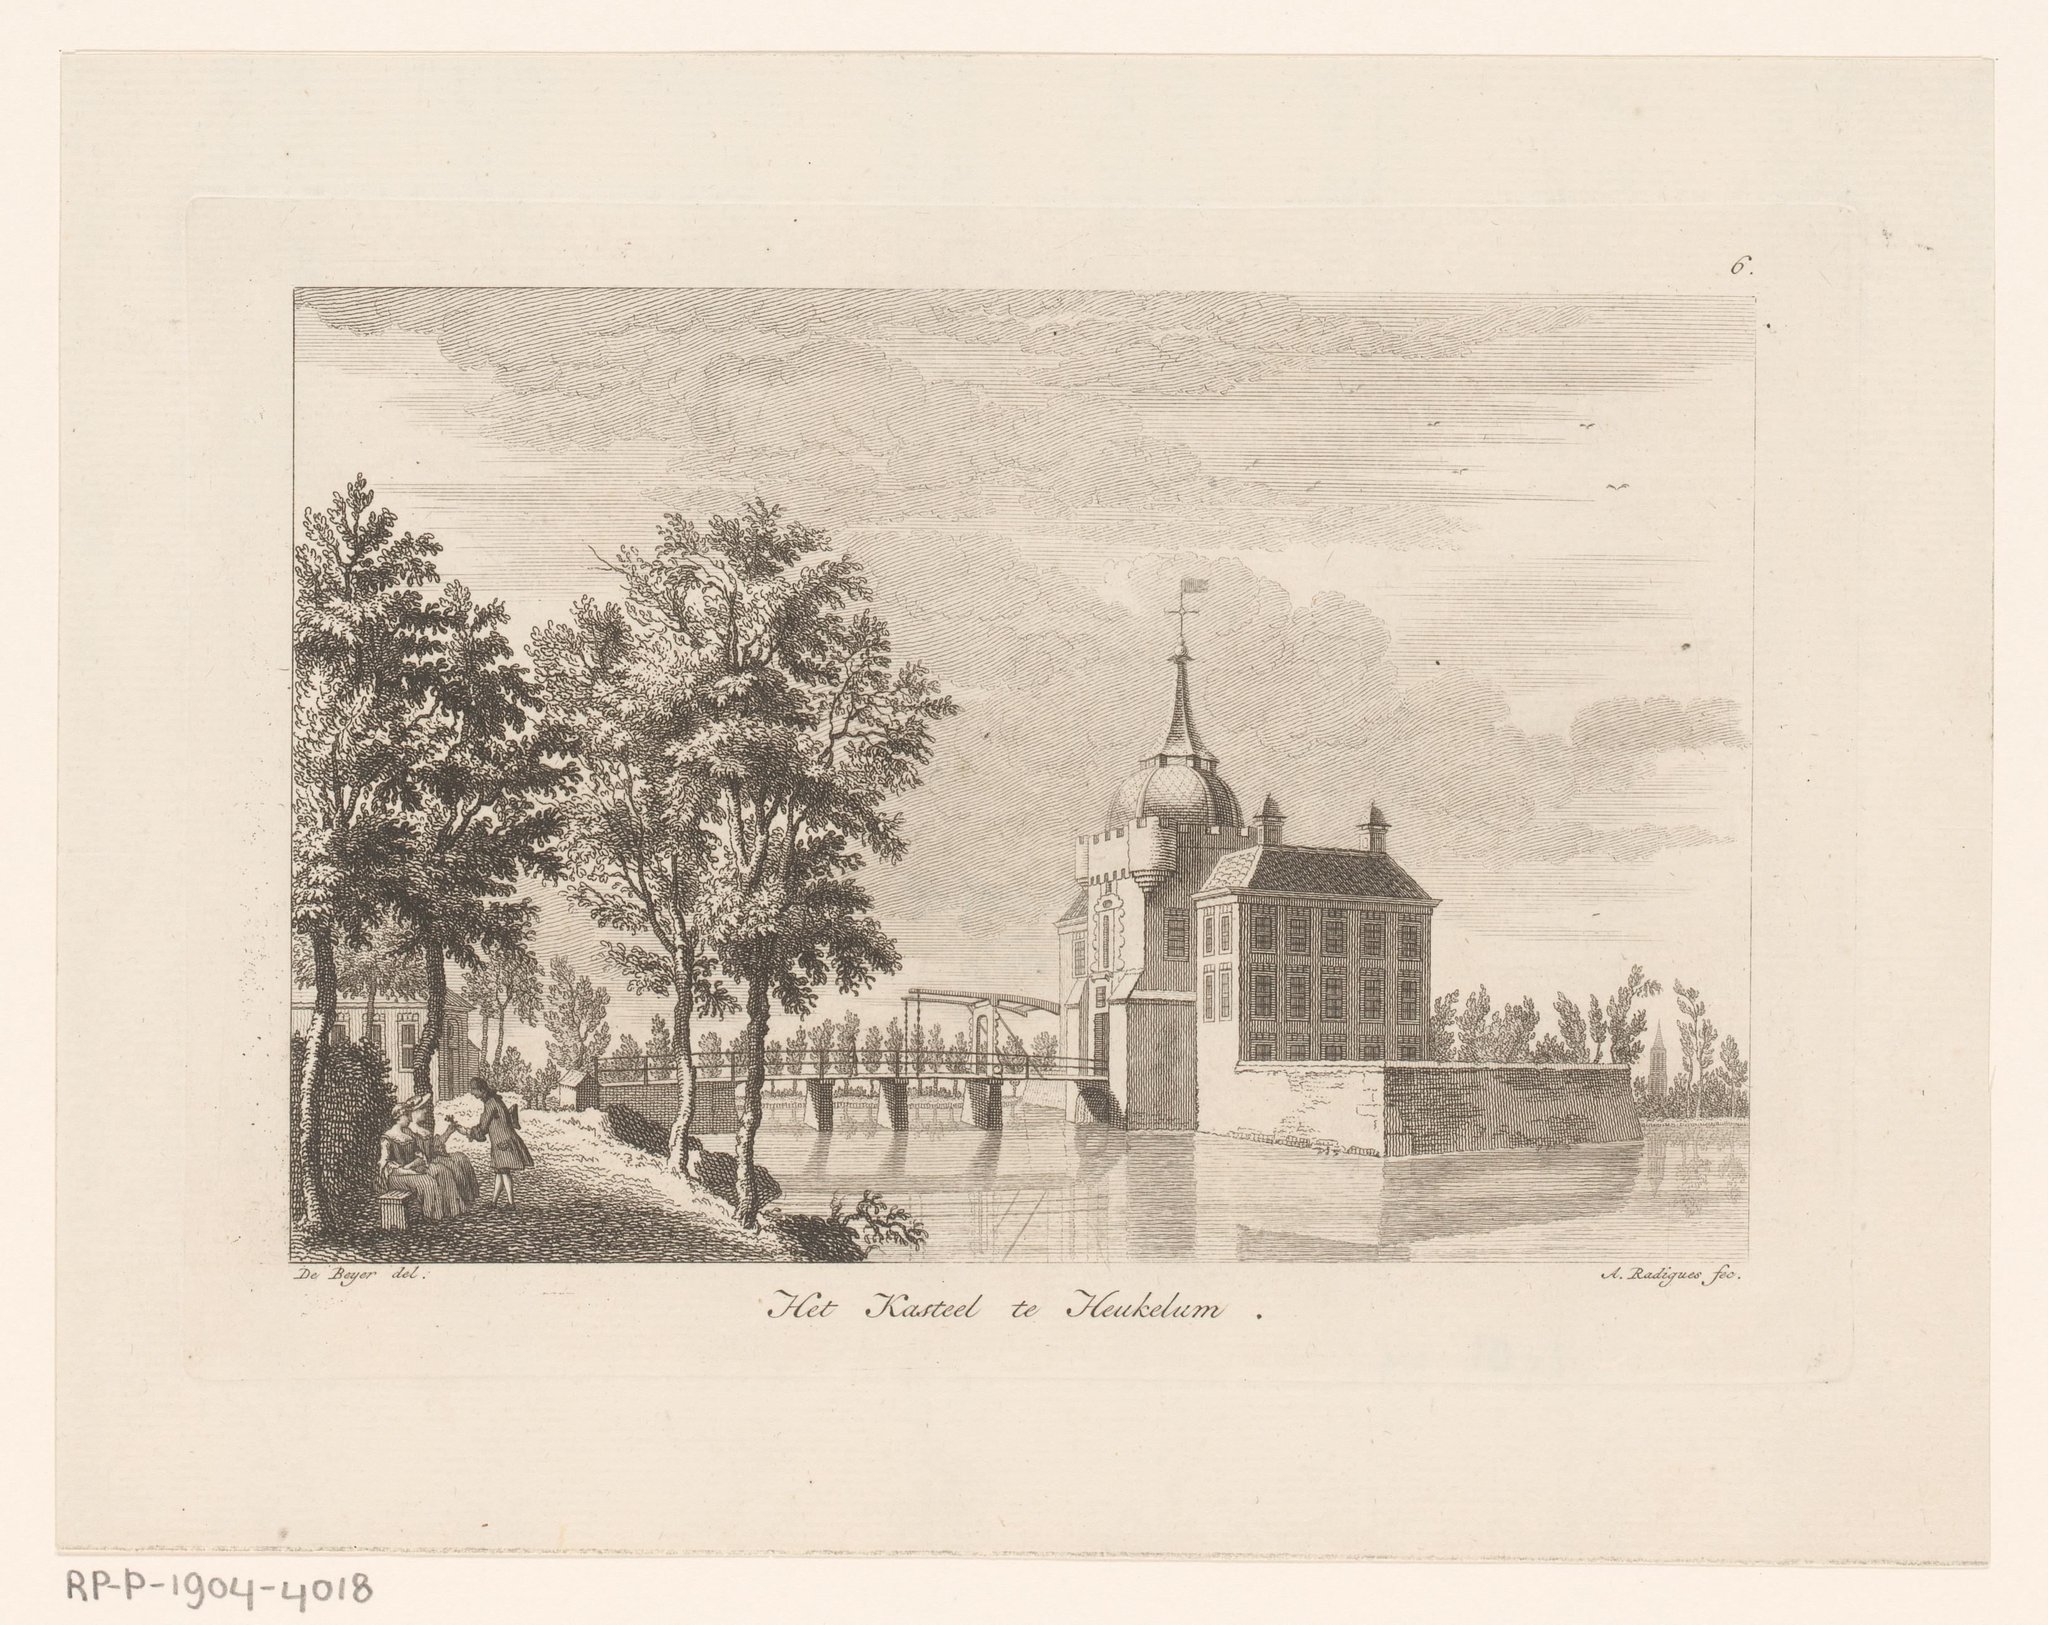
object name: print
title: Gezicht op Kasteel Merckenburg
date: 1731-1809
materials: paper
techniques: engraving, etching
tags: landscape with tower or castle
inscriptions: collector's mark: Lugt 2228